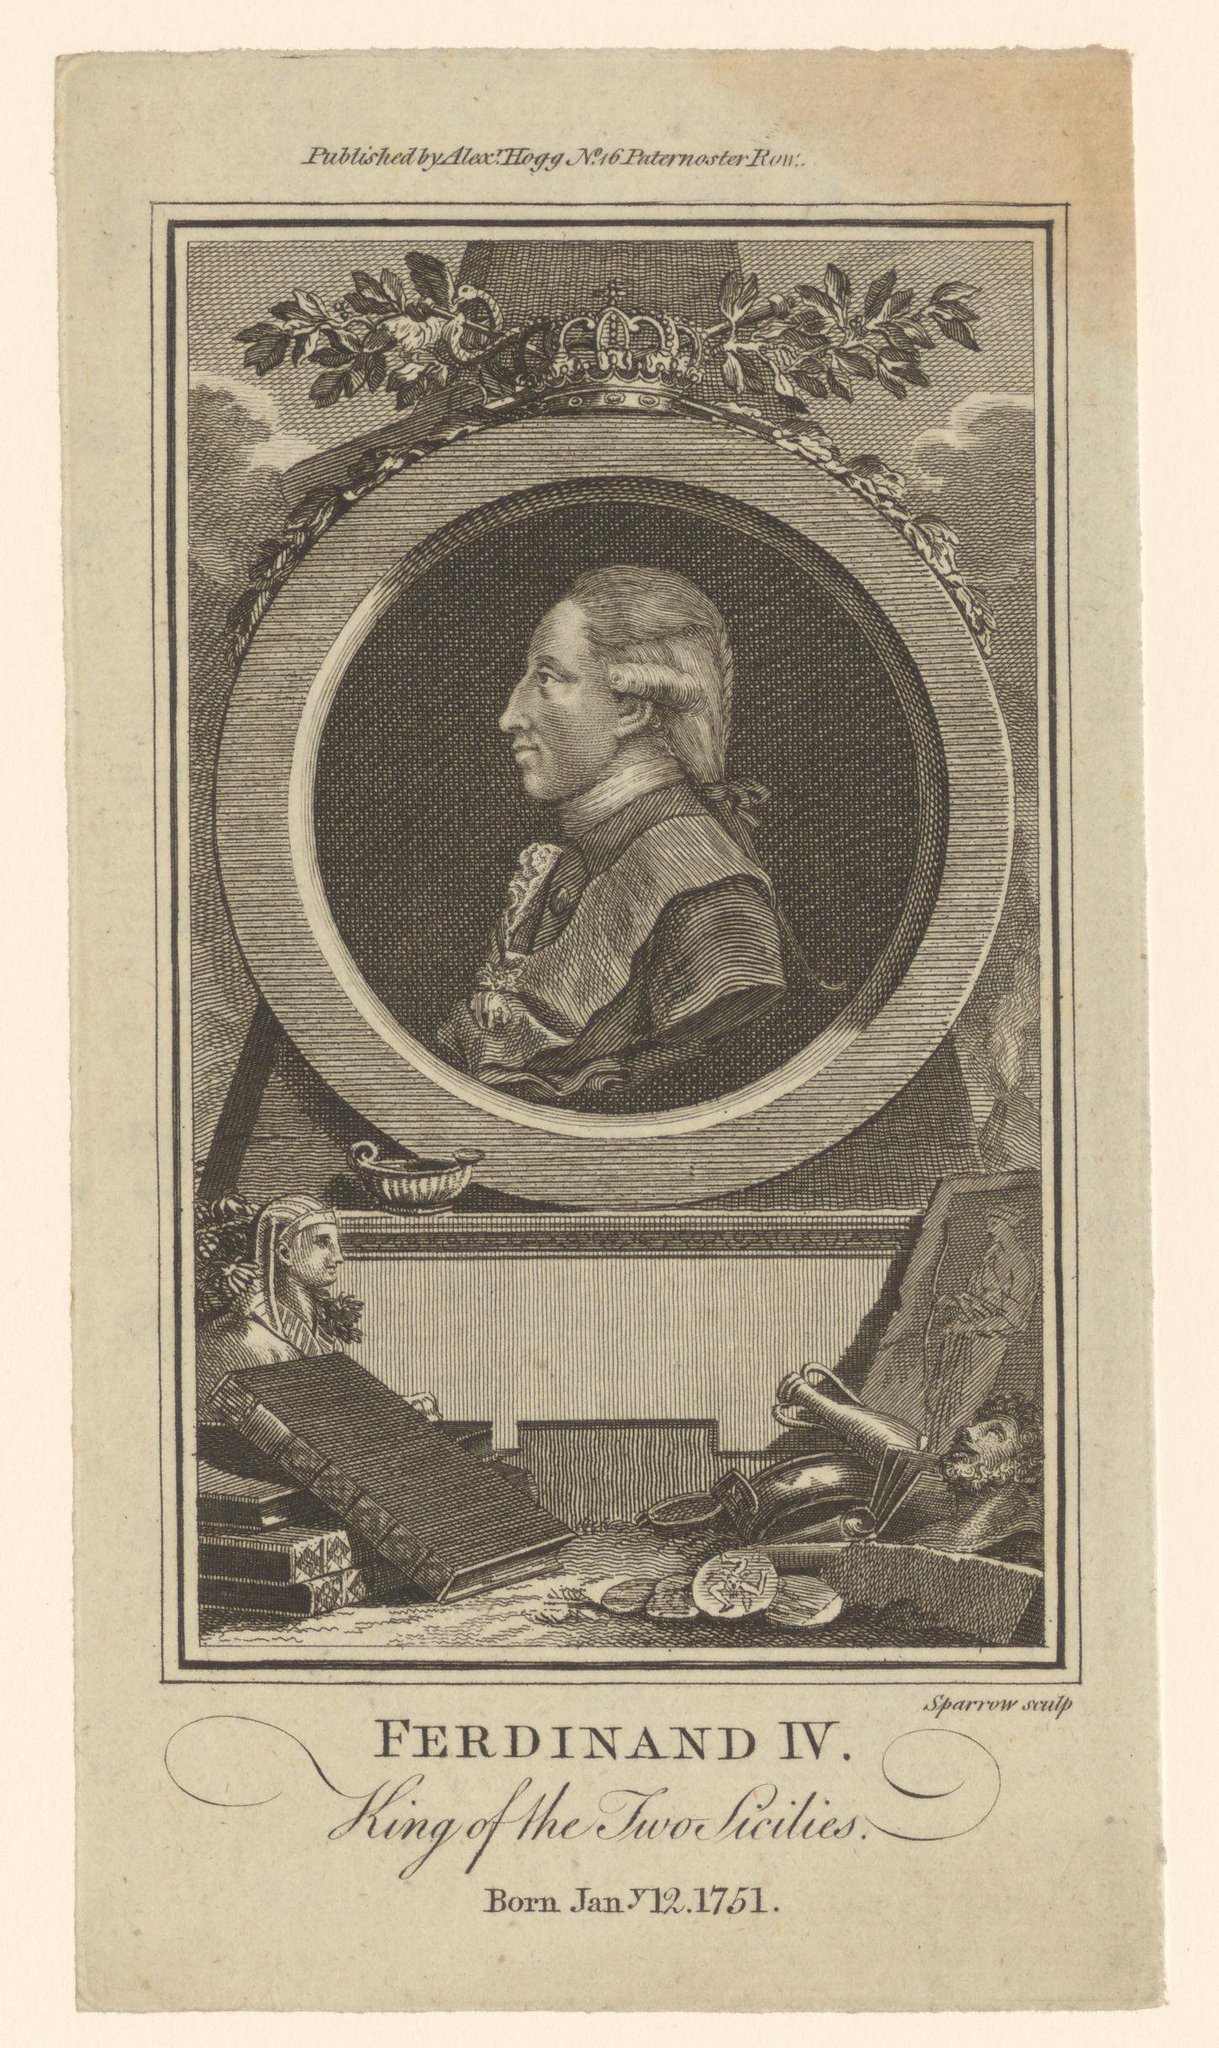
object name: print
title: Ferdinand IV, King of the Two Sicilies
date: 1785-1789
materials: paper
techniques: etching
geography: london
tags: ferdinand i (koning der beide siciliën), historical persons, king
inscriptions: collector's mark: Lugt 2228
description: Prent mogelijk uit een editie van The New London Magazine, 1785-1789.